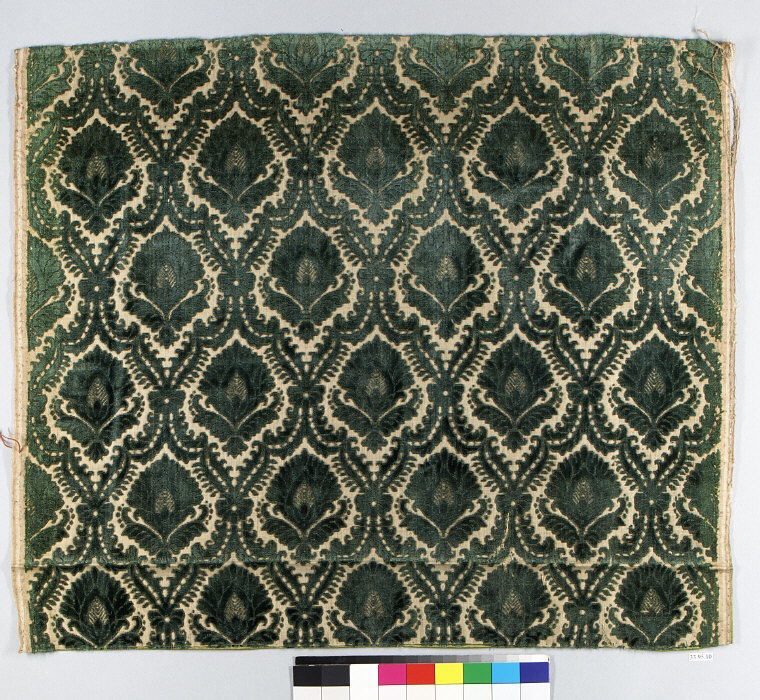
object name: fragment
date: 1567-1600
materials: silk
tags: leaves